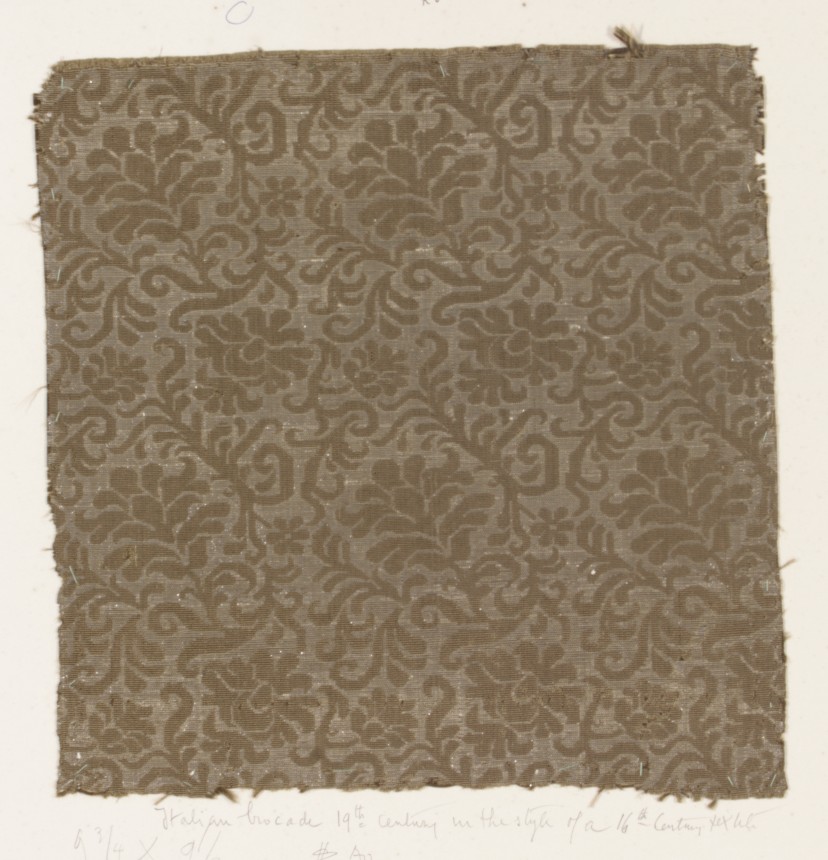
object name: fragment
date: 1801-1900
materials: metal thread, silk